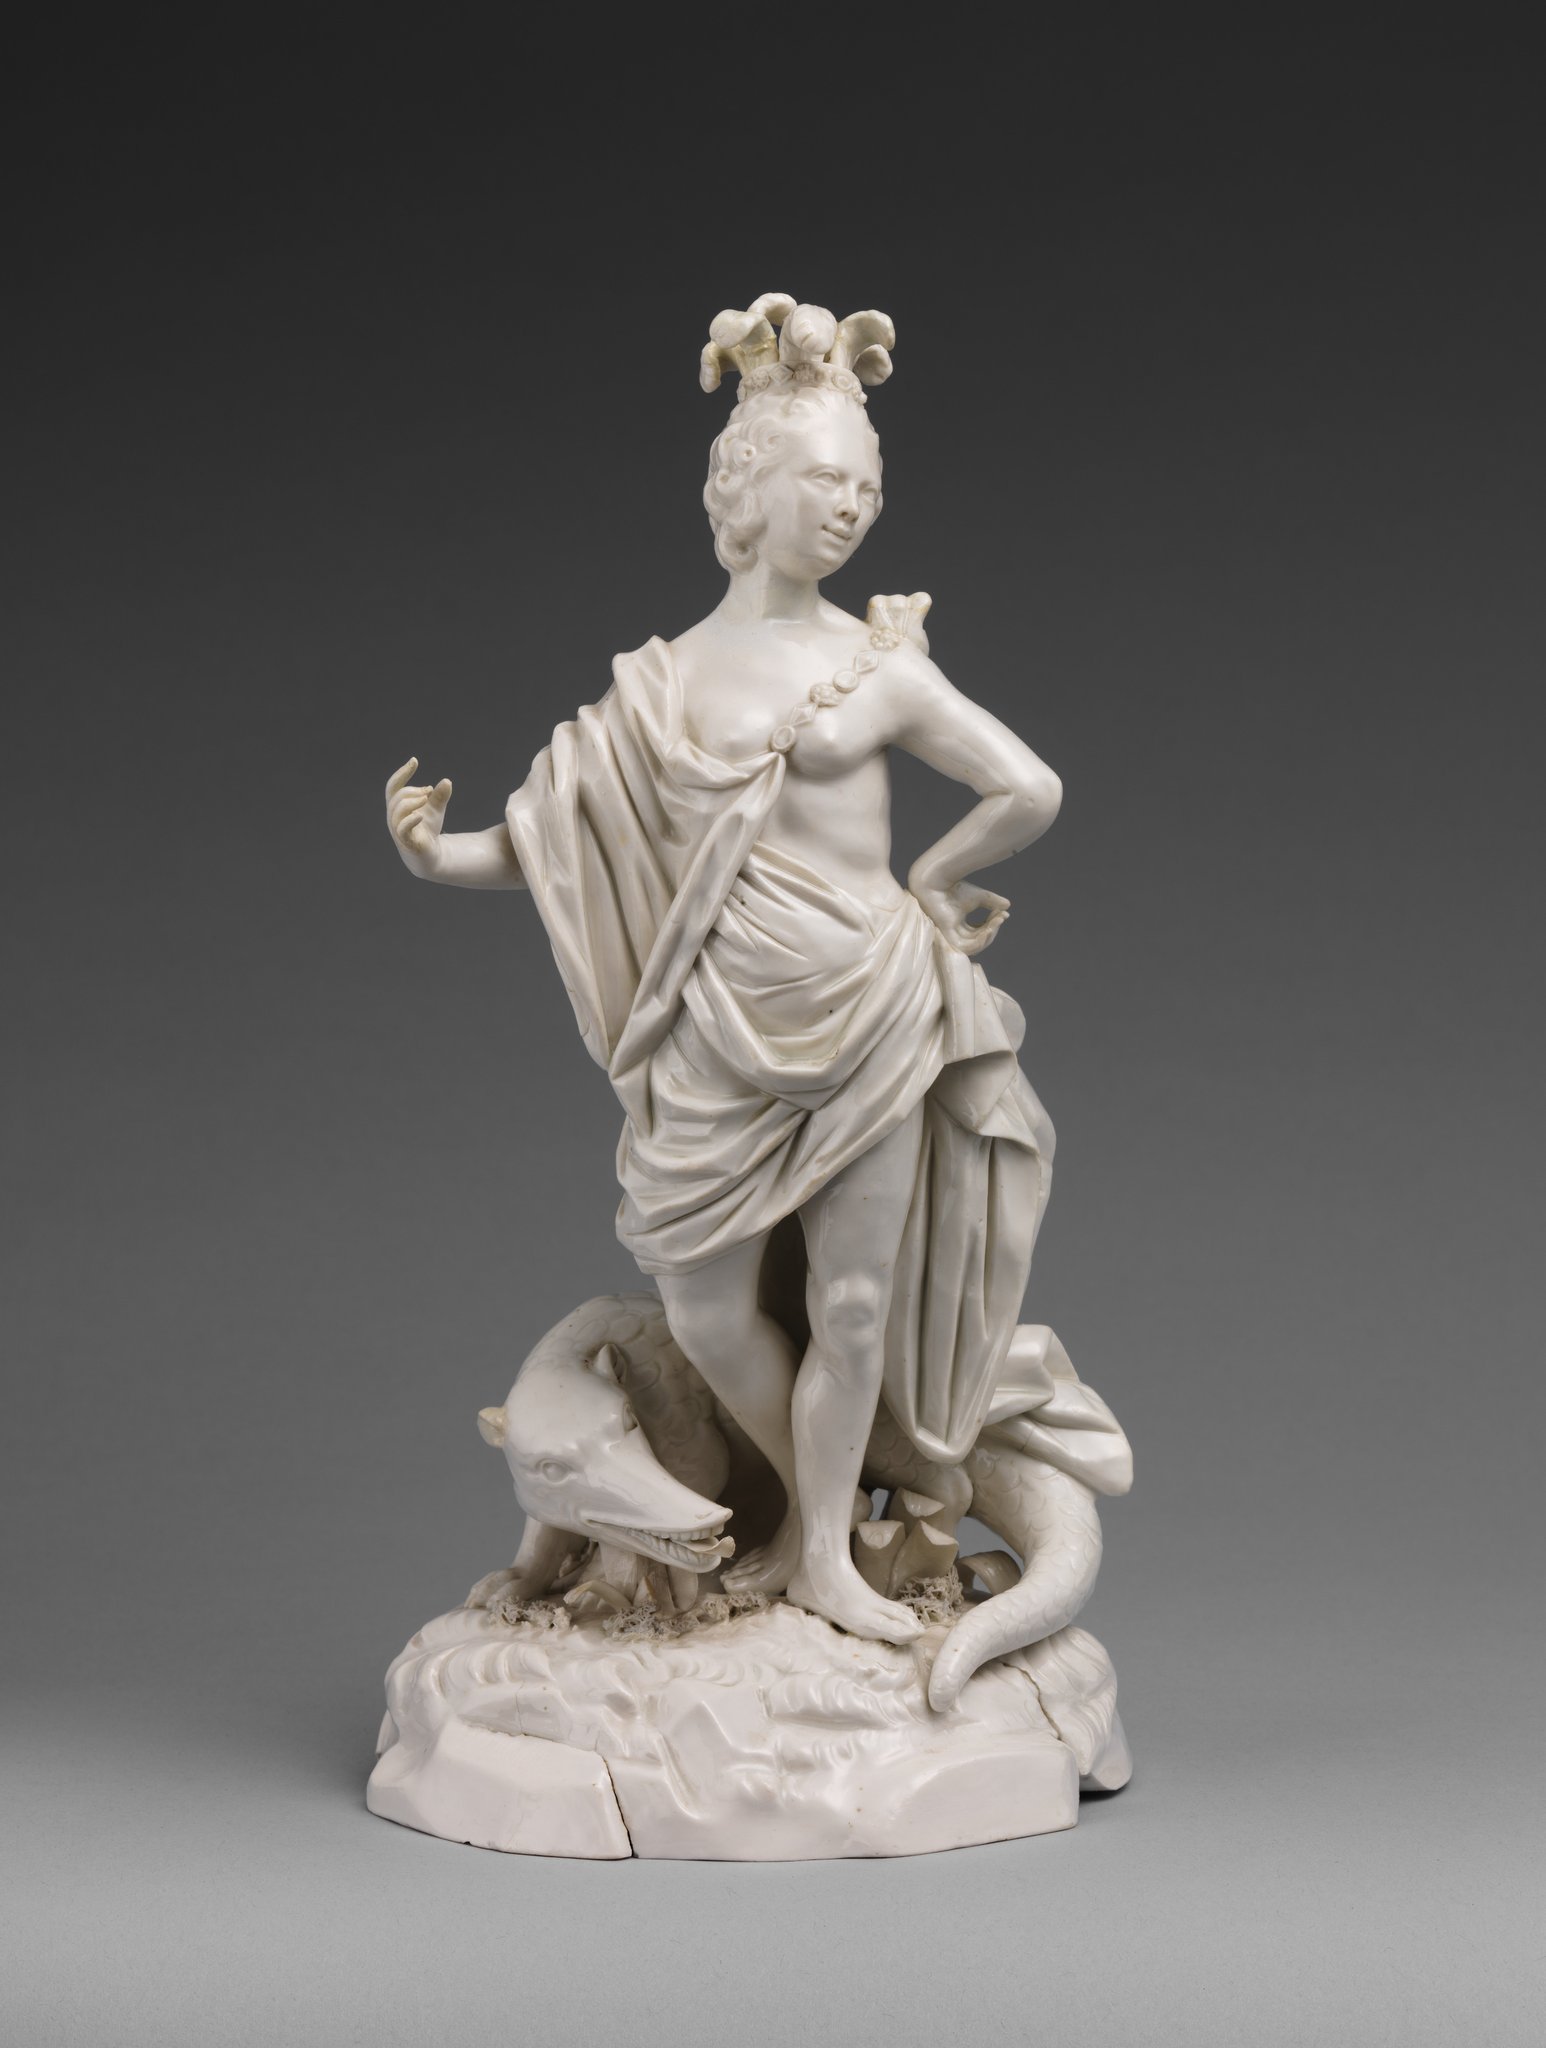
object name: figure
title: America, from Allegories of the Four Continents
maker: fulda pottery and porcelain manufactory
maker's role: manufactory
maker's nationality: german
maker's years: 1764-1789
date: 1781-1788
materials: hard paste porcelain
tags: animals,women